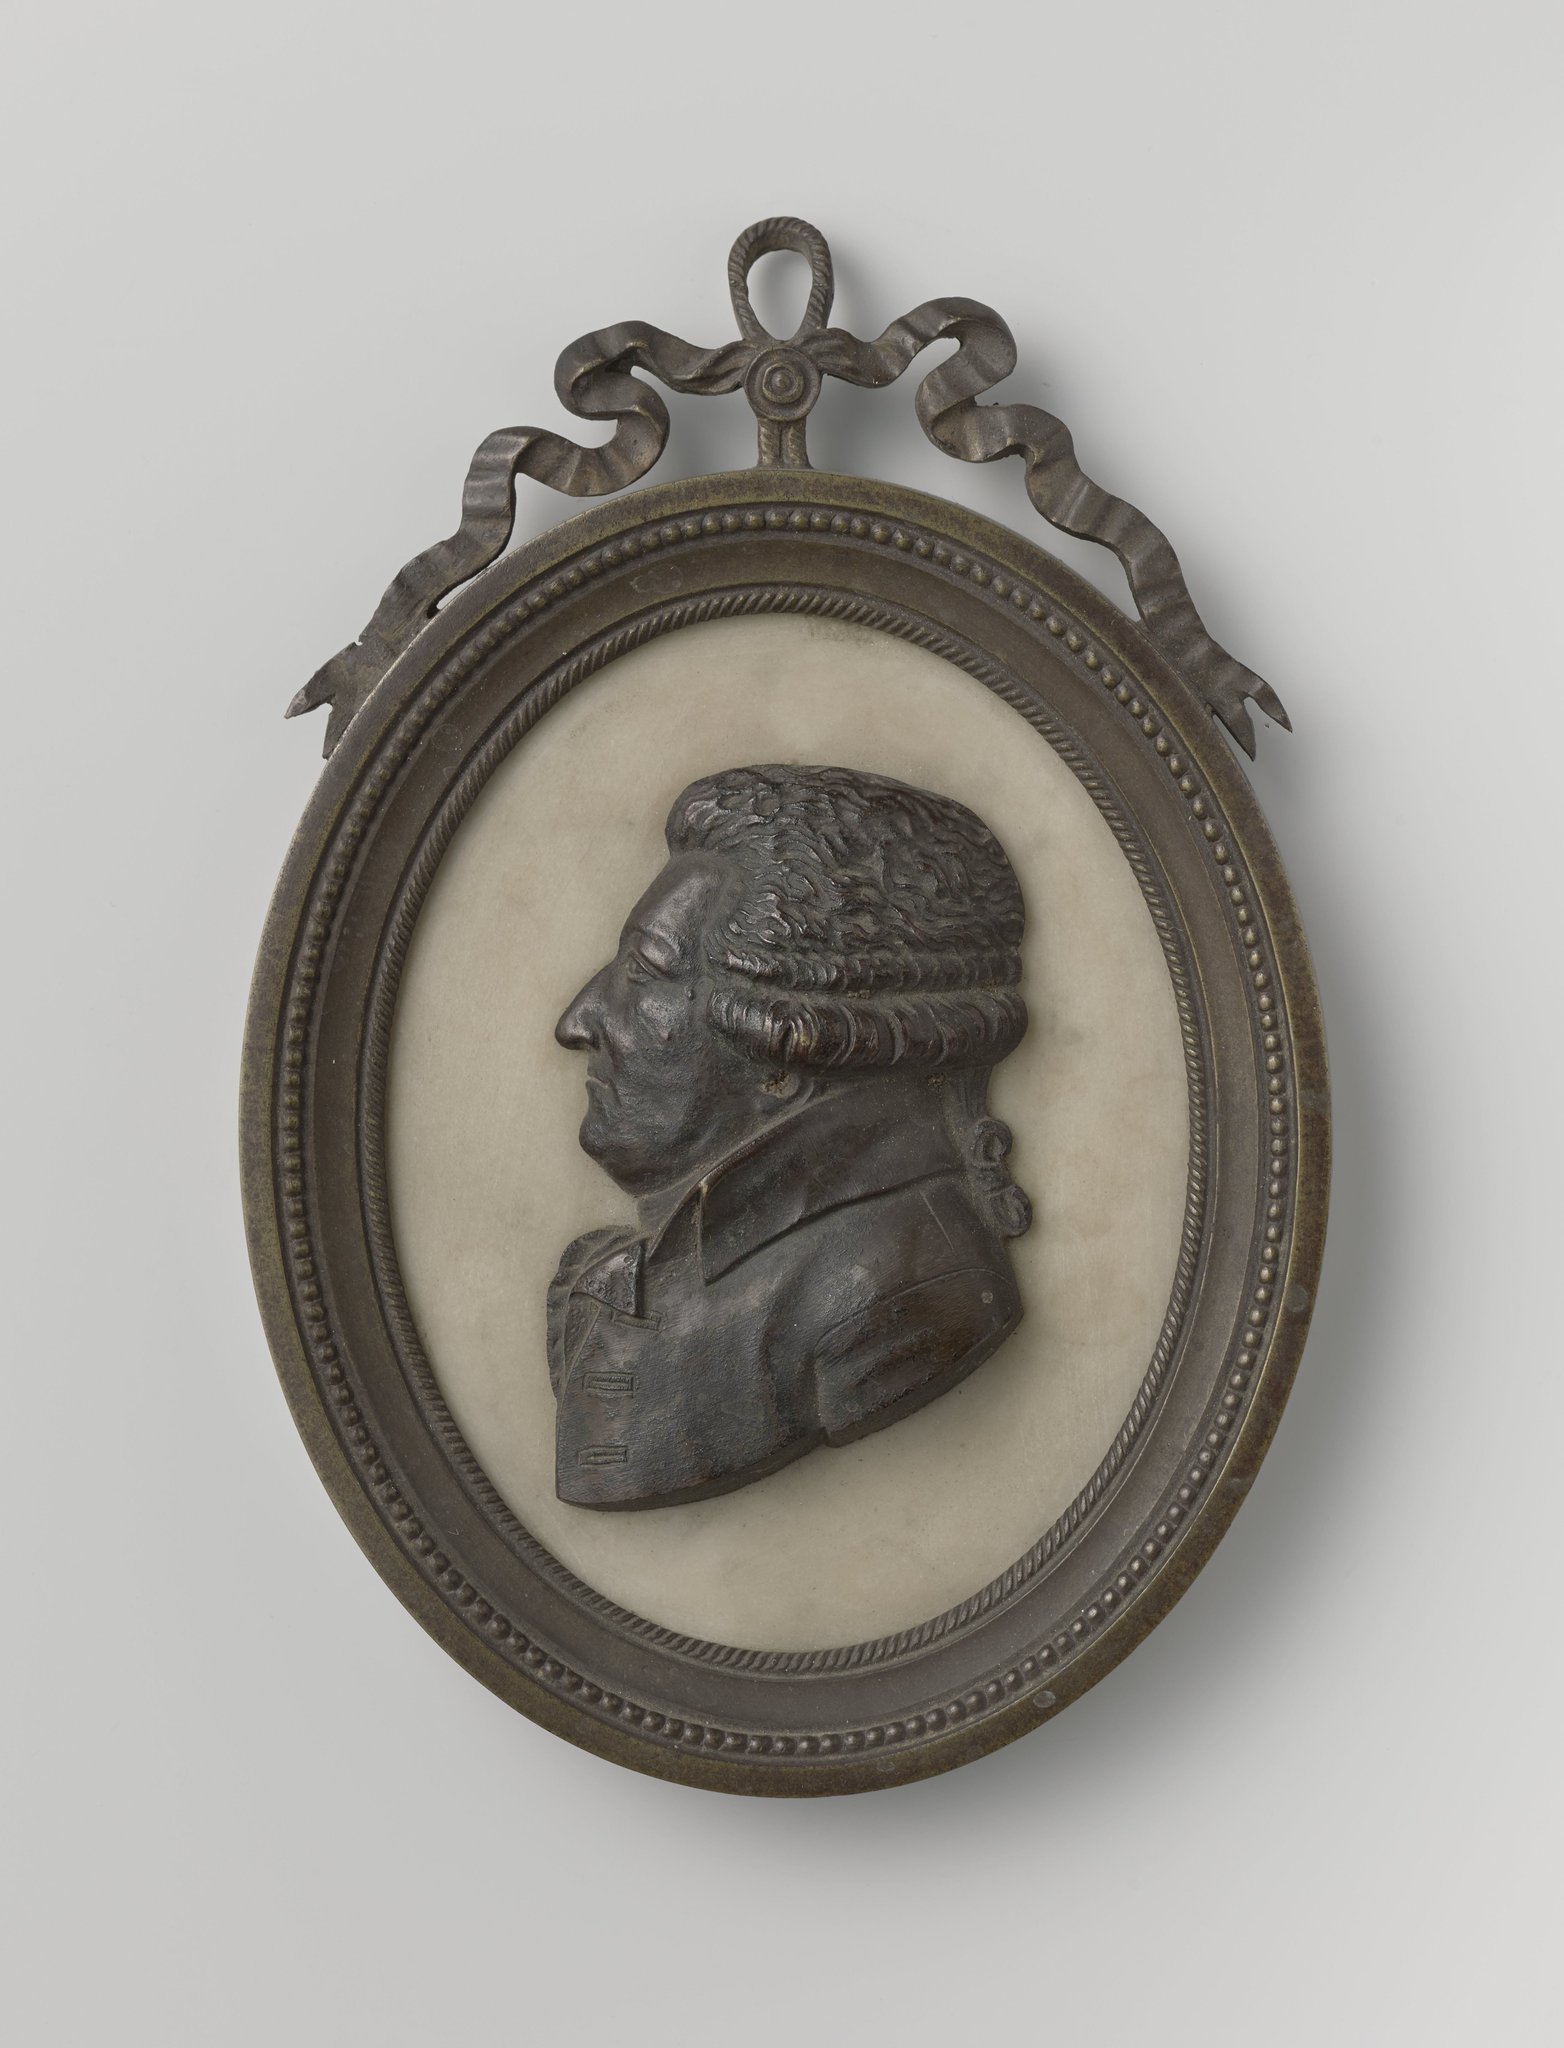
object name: sculpture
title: Ingelijst portret Mirabeau, en profil gezien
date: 1800-1900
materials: bronze, marble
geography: france